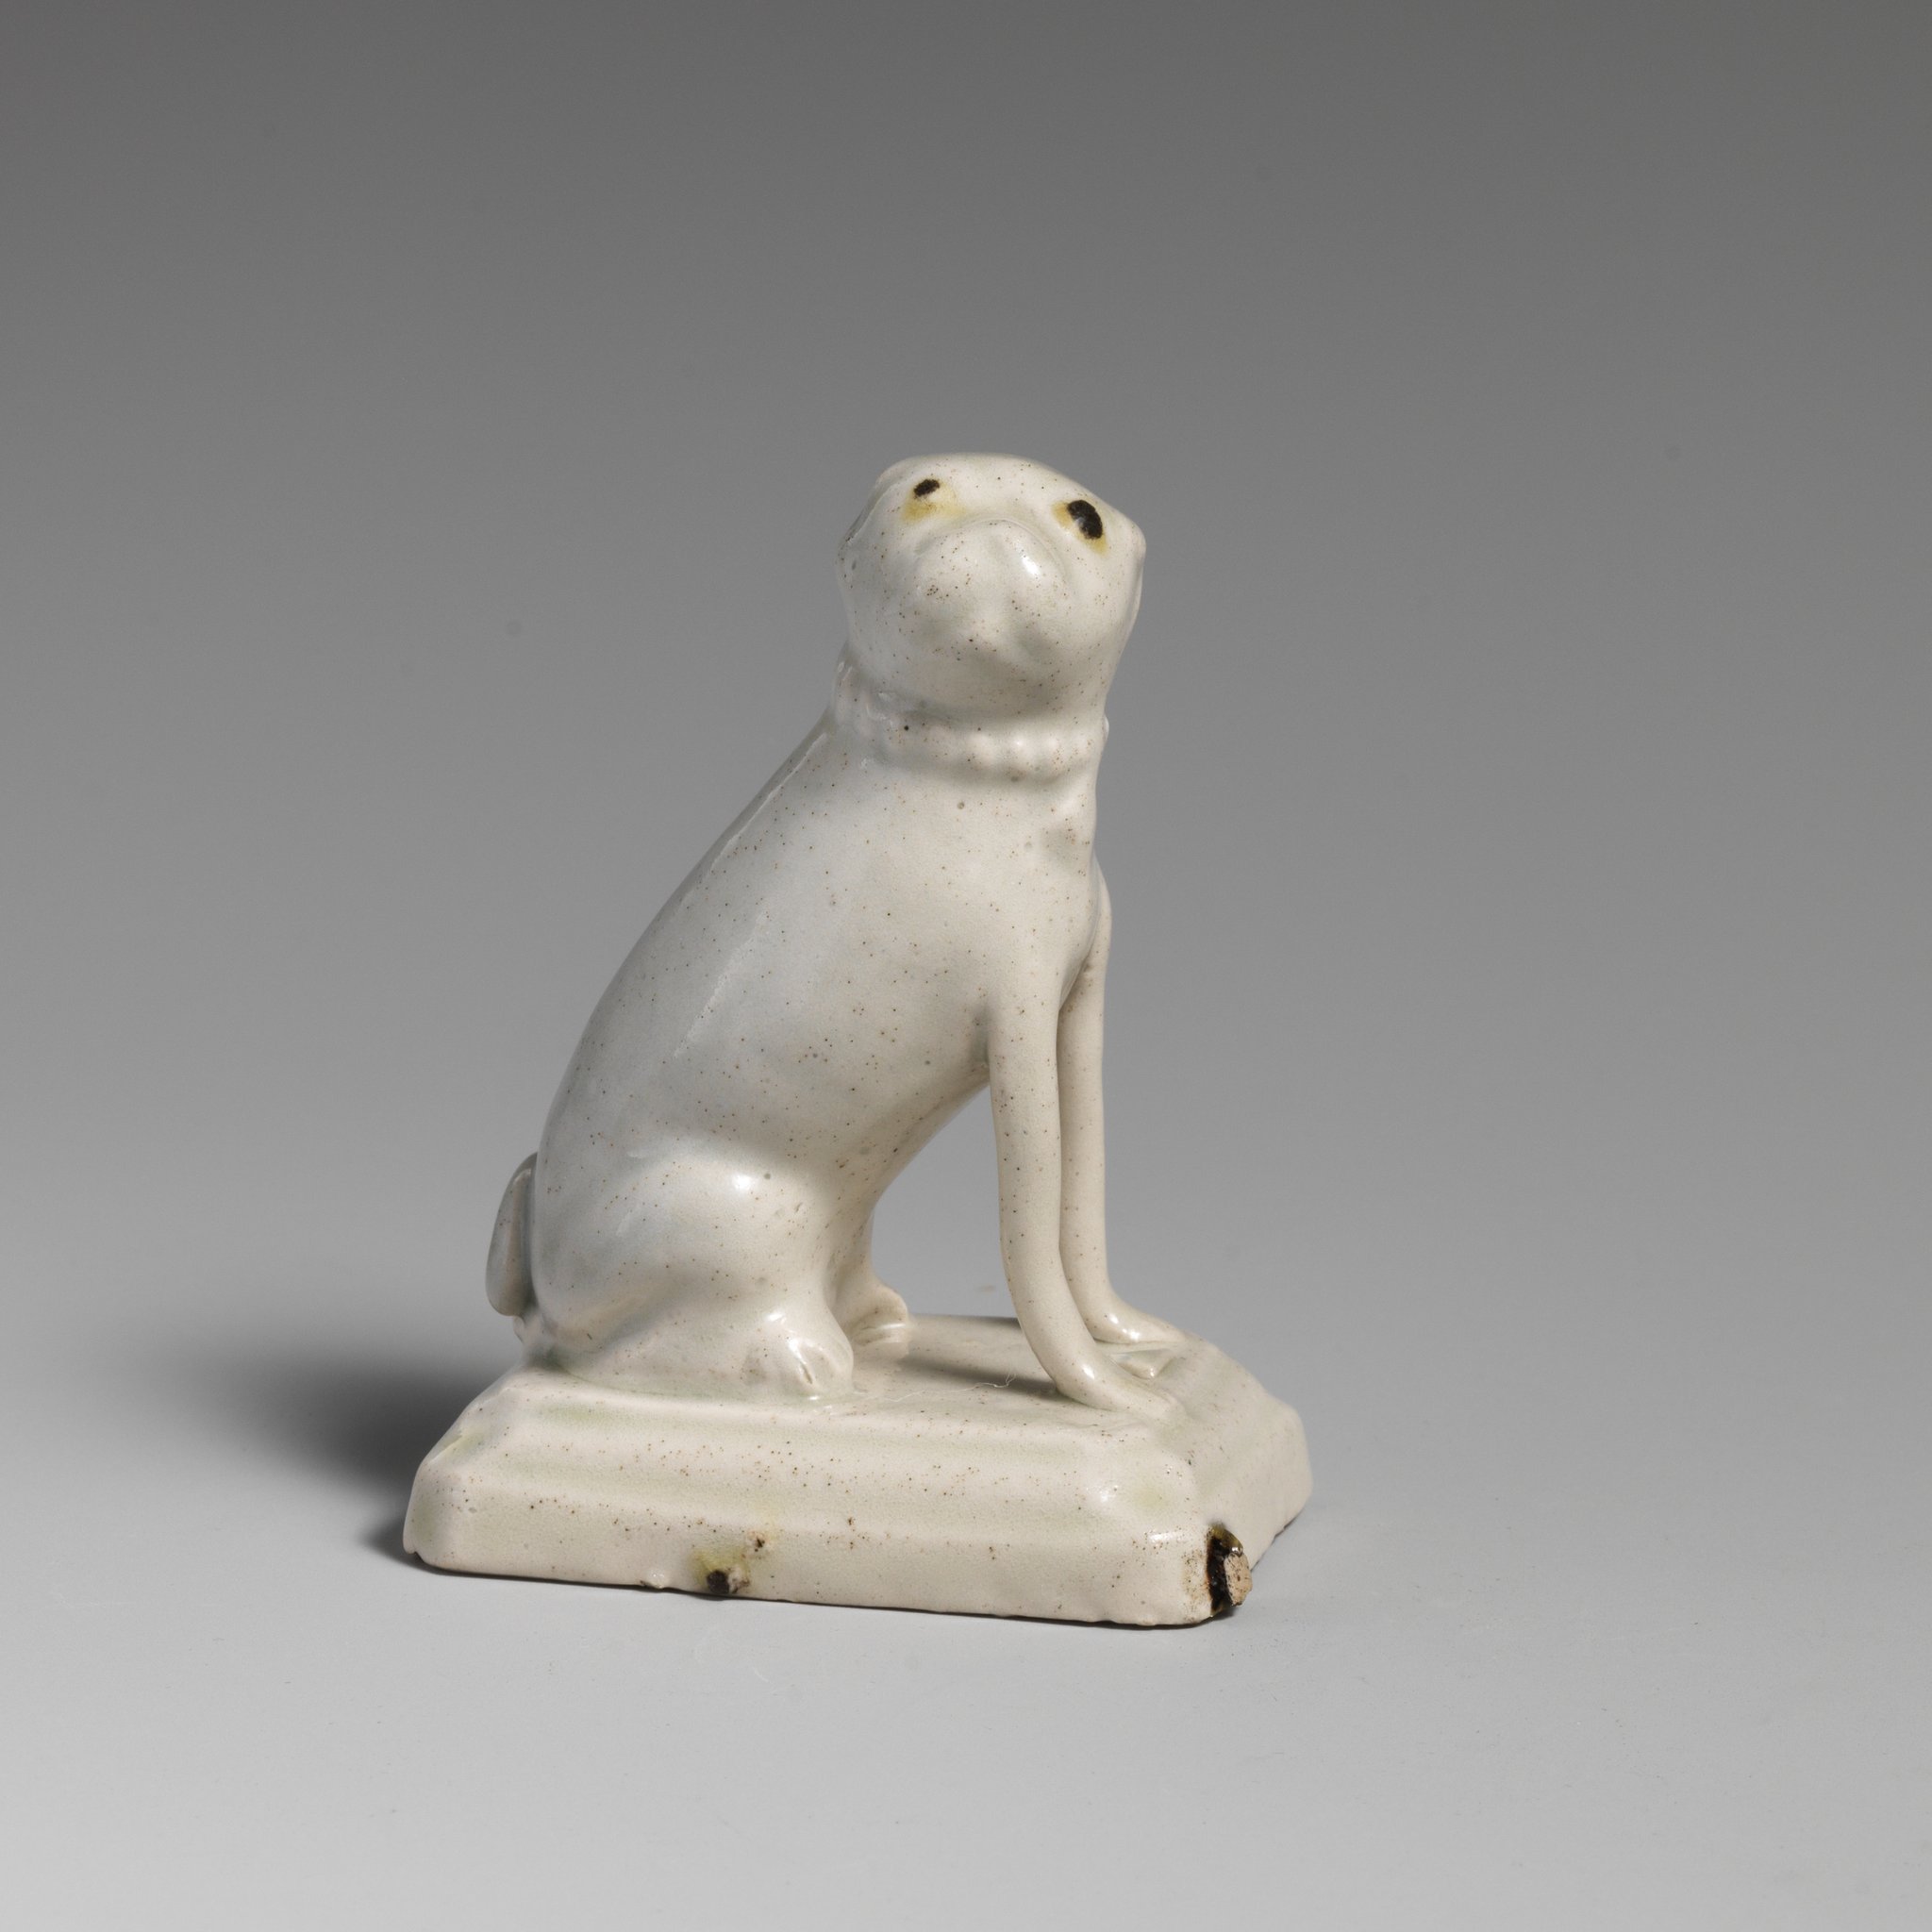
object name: figure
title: Pug dog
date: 1720-1740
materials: stoneware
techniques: salt glaze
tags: dogs